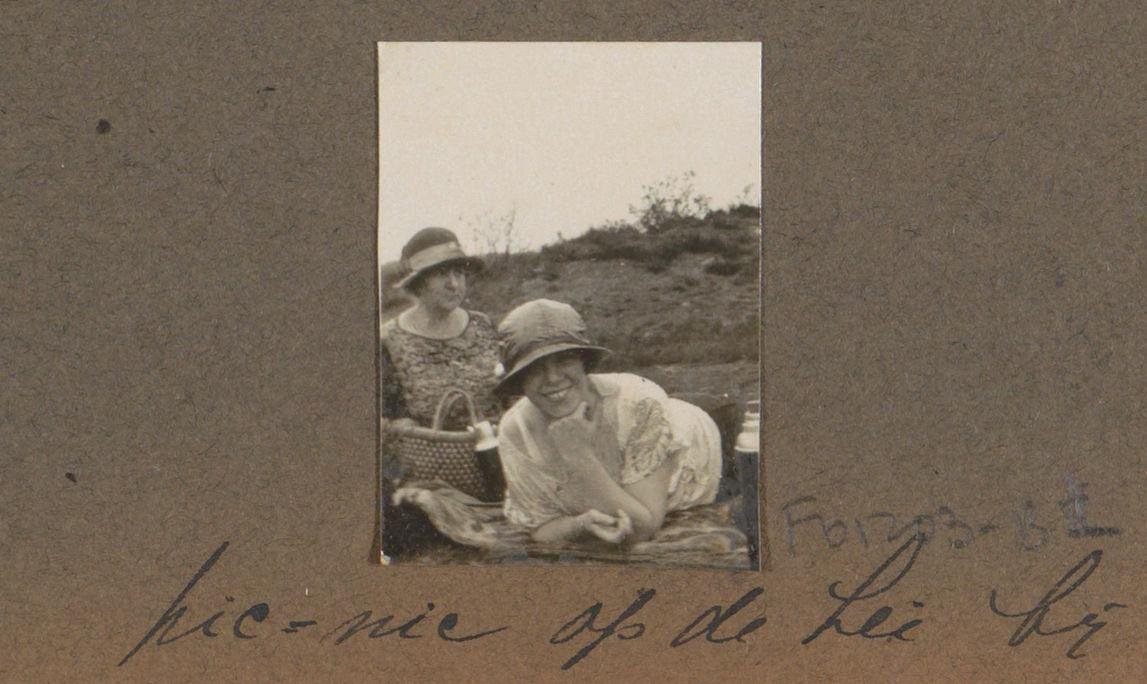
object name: photograph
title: Pic-nic op de hei bij Amersfoort, mei '24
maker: Anonymous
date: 1905-1924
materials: photographic support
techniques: gelatin silver print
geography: amersfoort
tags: head-gear: hat, eating and drinking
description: Onderdeel van fotoalbum van een onbekende Nederlandse familie met opnames van Suriname, Europa en Nederlands-Indië.